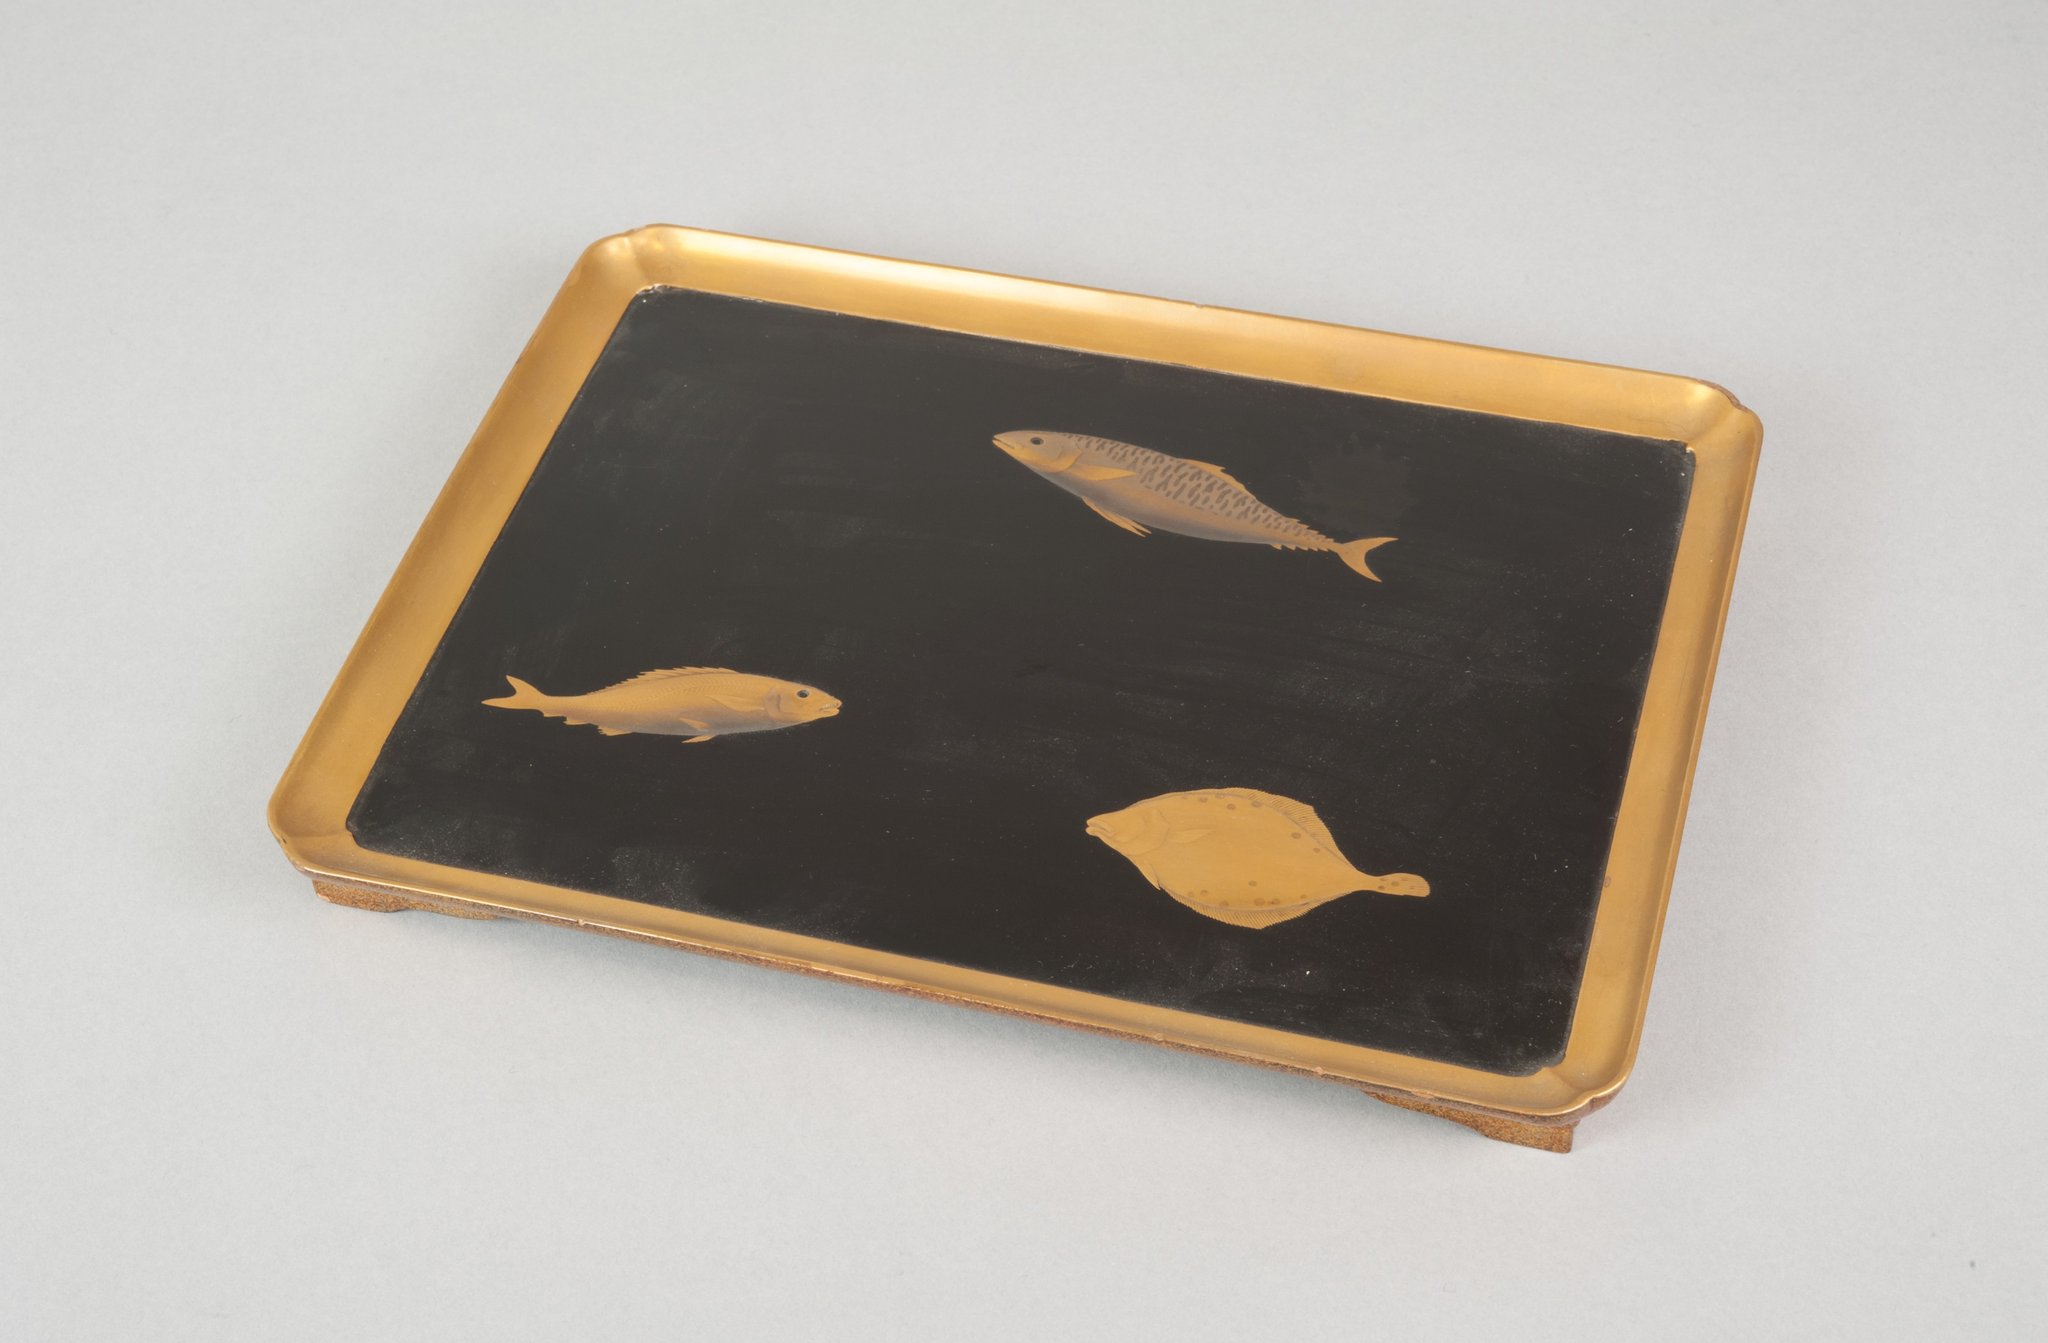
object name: tray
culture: japanese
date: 1801-1900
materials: lacquer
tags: fish